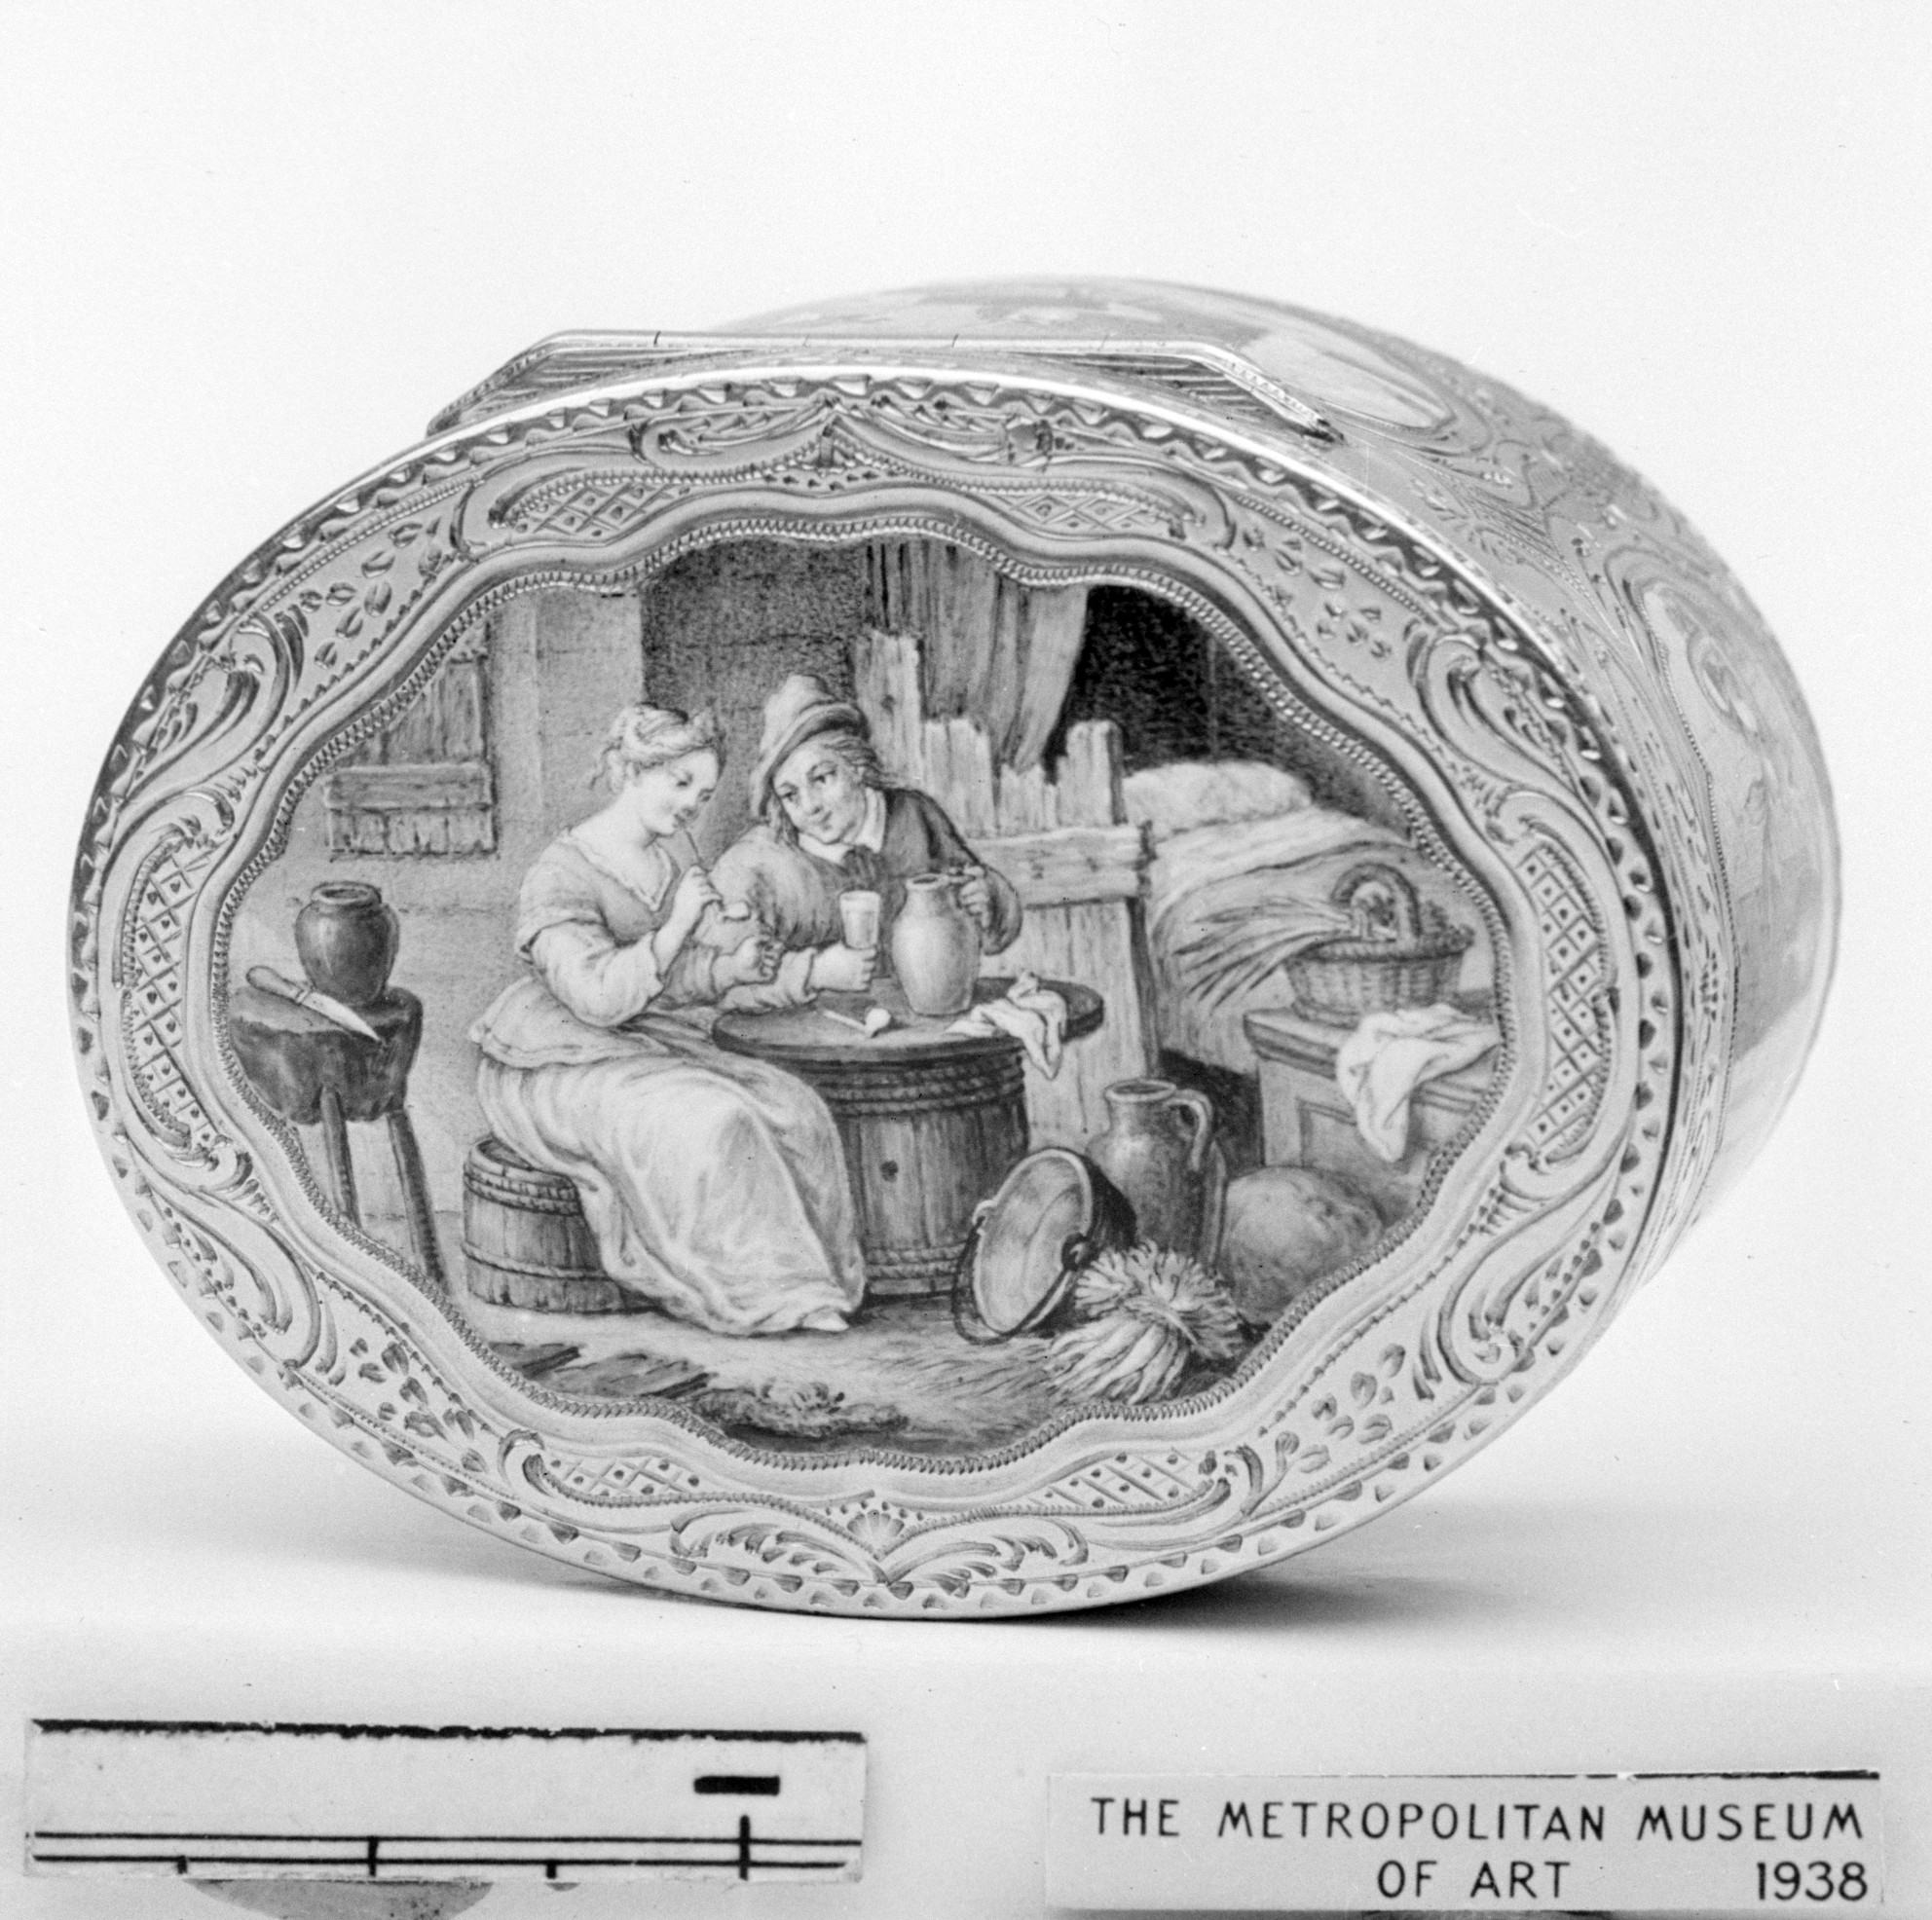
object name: snuffbox, painting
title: Snuffbox with domestic scenes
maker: mathieu coiny fils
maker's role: maker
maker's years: 1723-1823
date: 1757-1758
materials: enamel, gold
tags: men,women,smoking,drinking